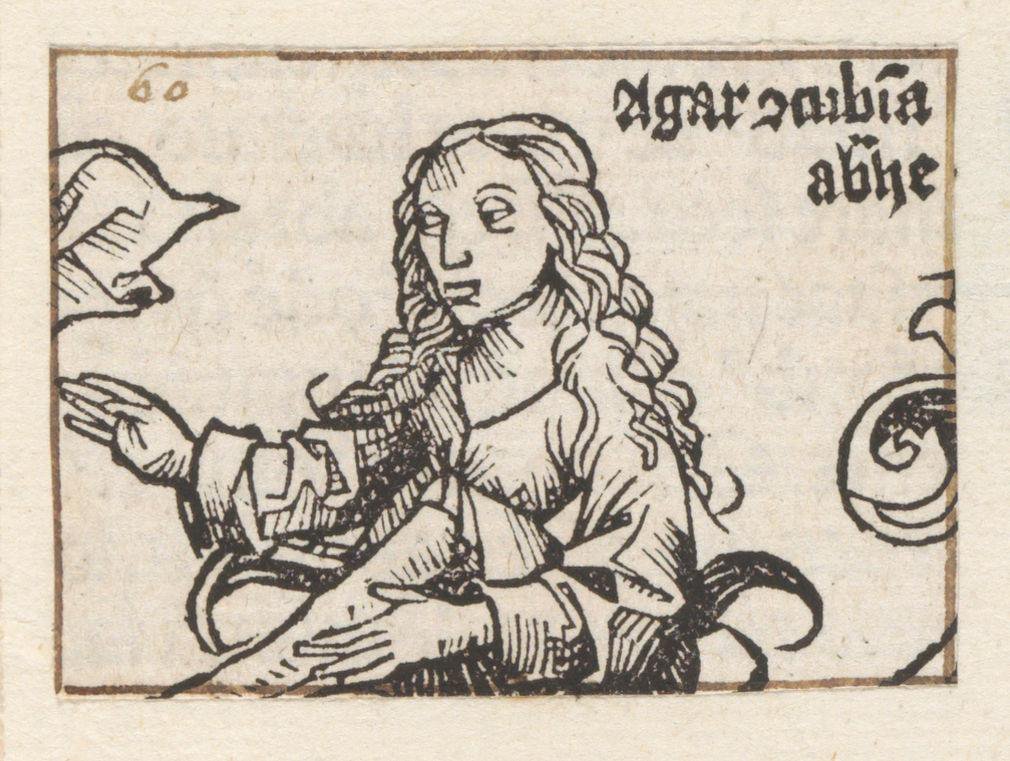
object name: book illustration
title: Hagar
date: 1493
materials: paper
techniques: letterpress printing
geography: nuremberg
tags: persons from the old testament (not in biblical context, nor occurring in legendary/historical extensions included in division 71)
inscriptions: inscription: ‘60’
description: Een bloemkelk met een vrouw met losse haren, naar links gekeerd. De tekst identificeert haar als Hagar, de tweede vrouw van Abraham. De voorstelling is een fragment van de stamboom van Christus in de Liber Chronicarum. De prent maakt deel uit van een album.